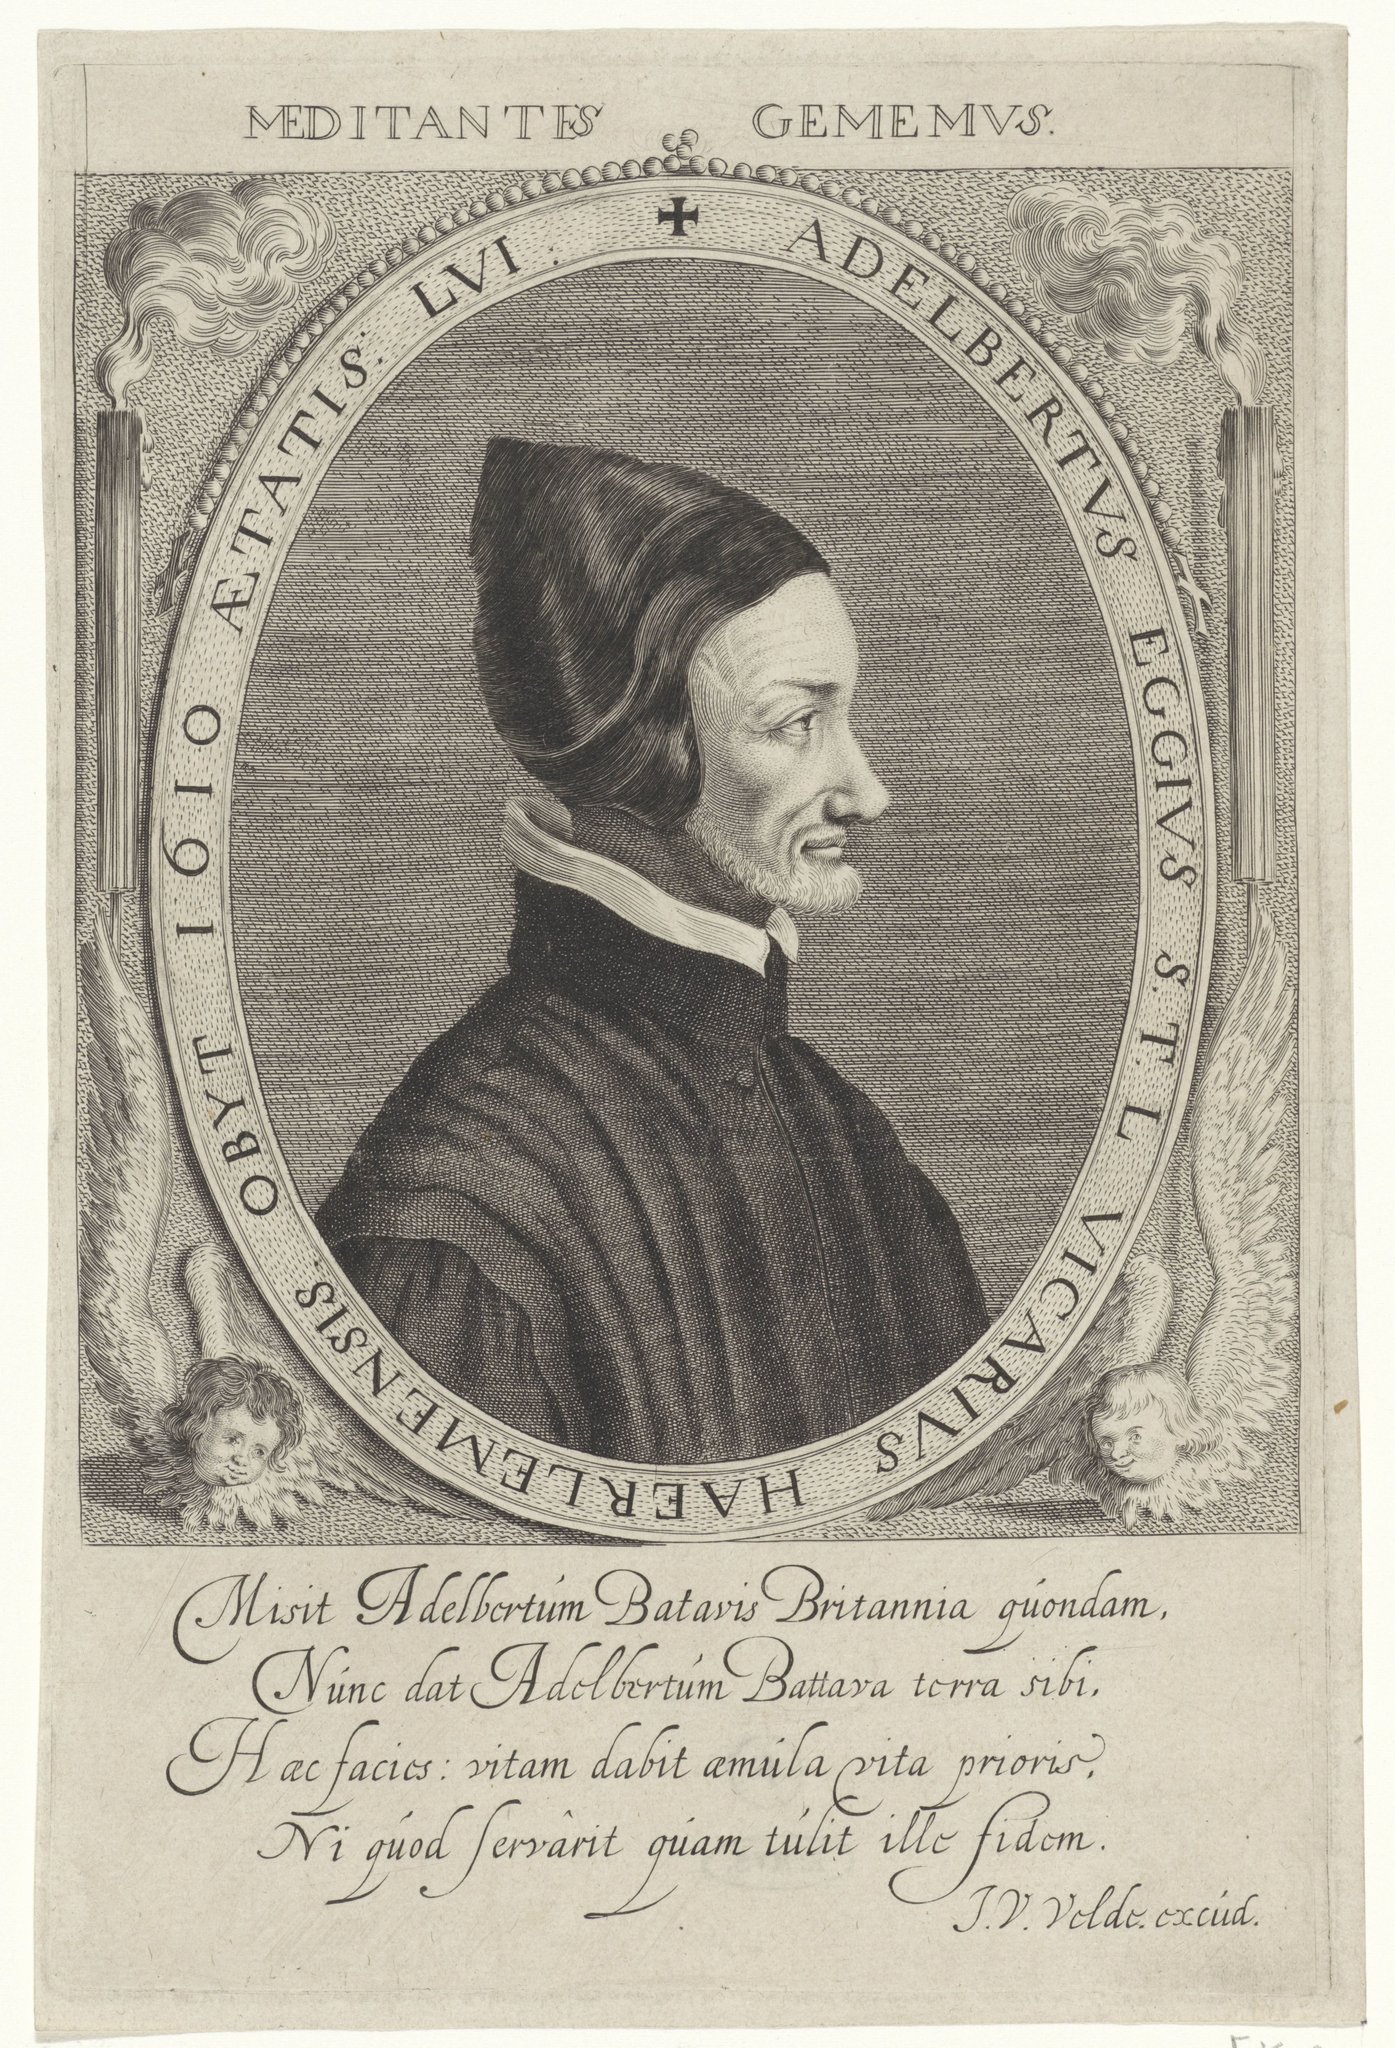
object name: print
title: Portret van Adelbertus Eggius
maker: jan van de velde (ii)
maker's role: draughtsman, painter, print maker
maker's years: 1593-1641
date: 1610-1641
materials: paper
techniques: engraving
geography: northern netherlands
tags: priest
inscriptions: collector's mark: Lugt 964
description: Portret van Adelbertus Gerbrandsz. Eggius, kapelaan te Haarlem.